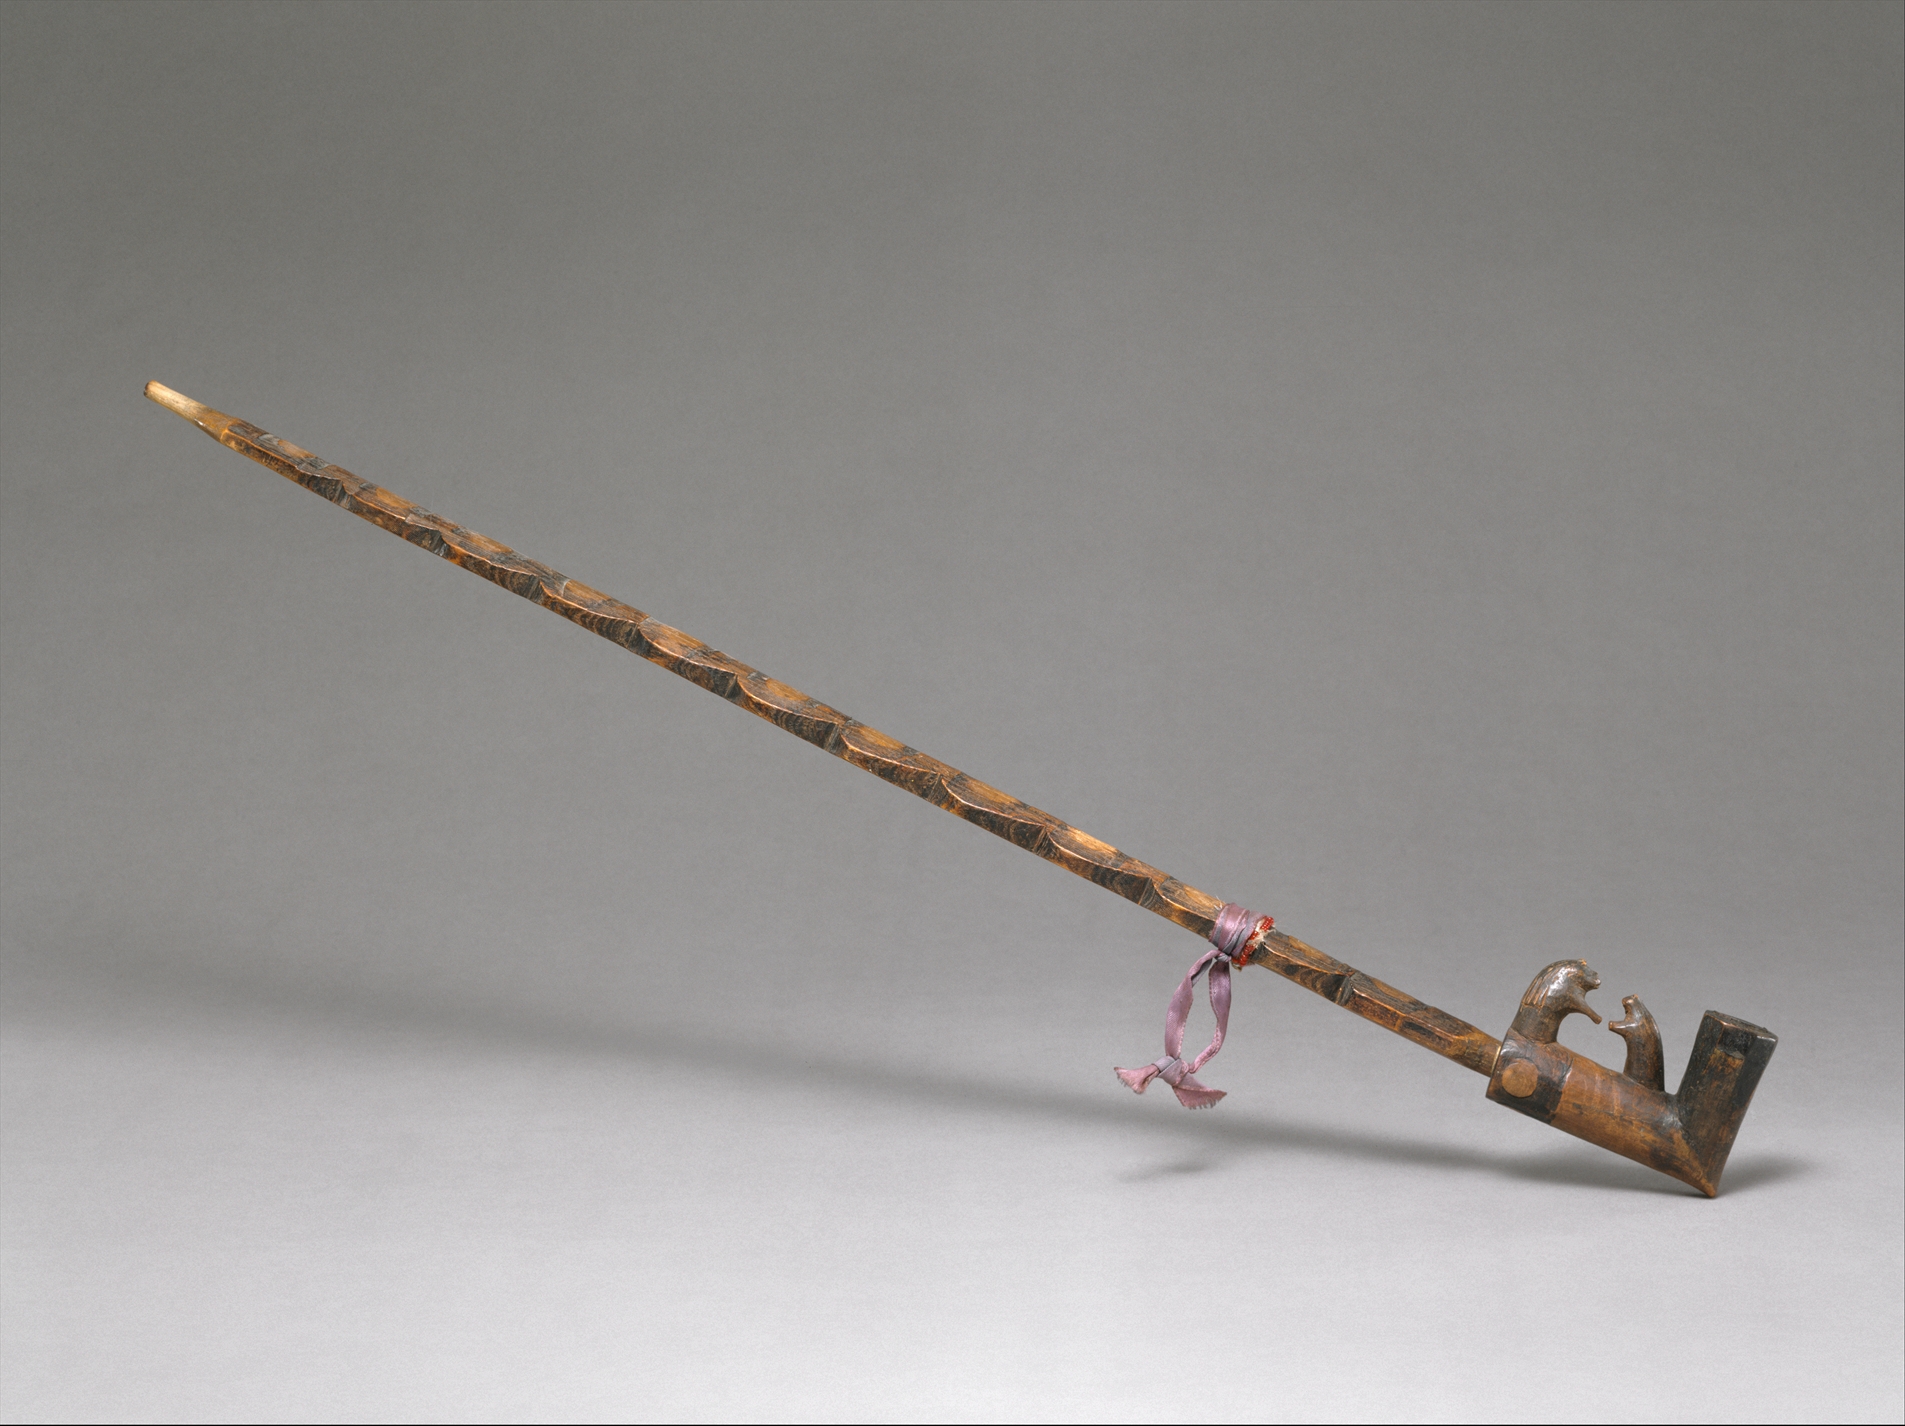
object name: pipe bowl and stem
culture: great lakes or plains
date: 1840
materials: metal, pigment, ribbon, silk, wood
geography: united states